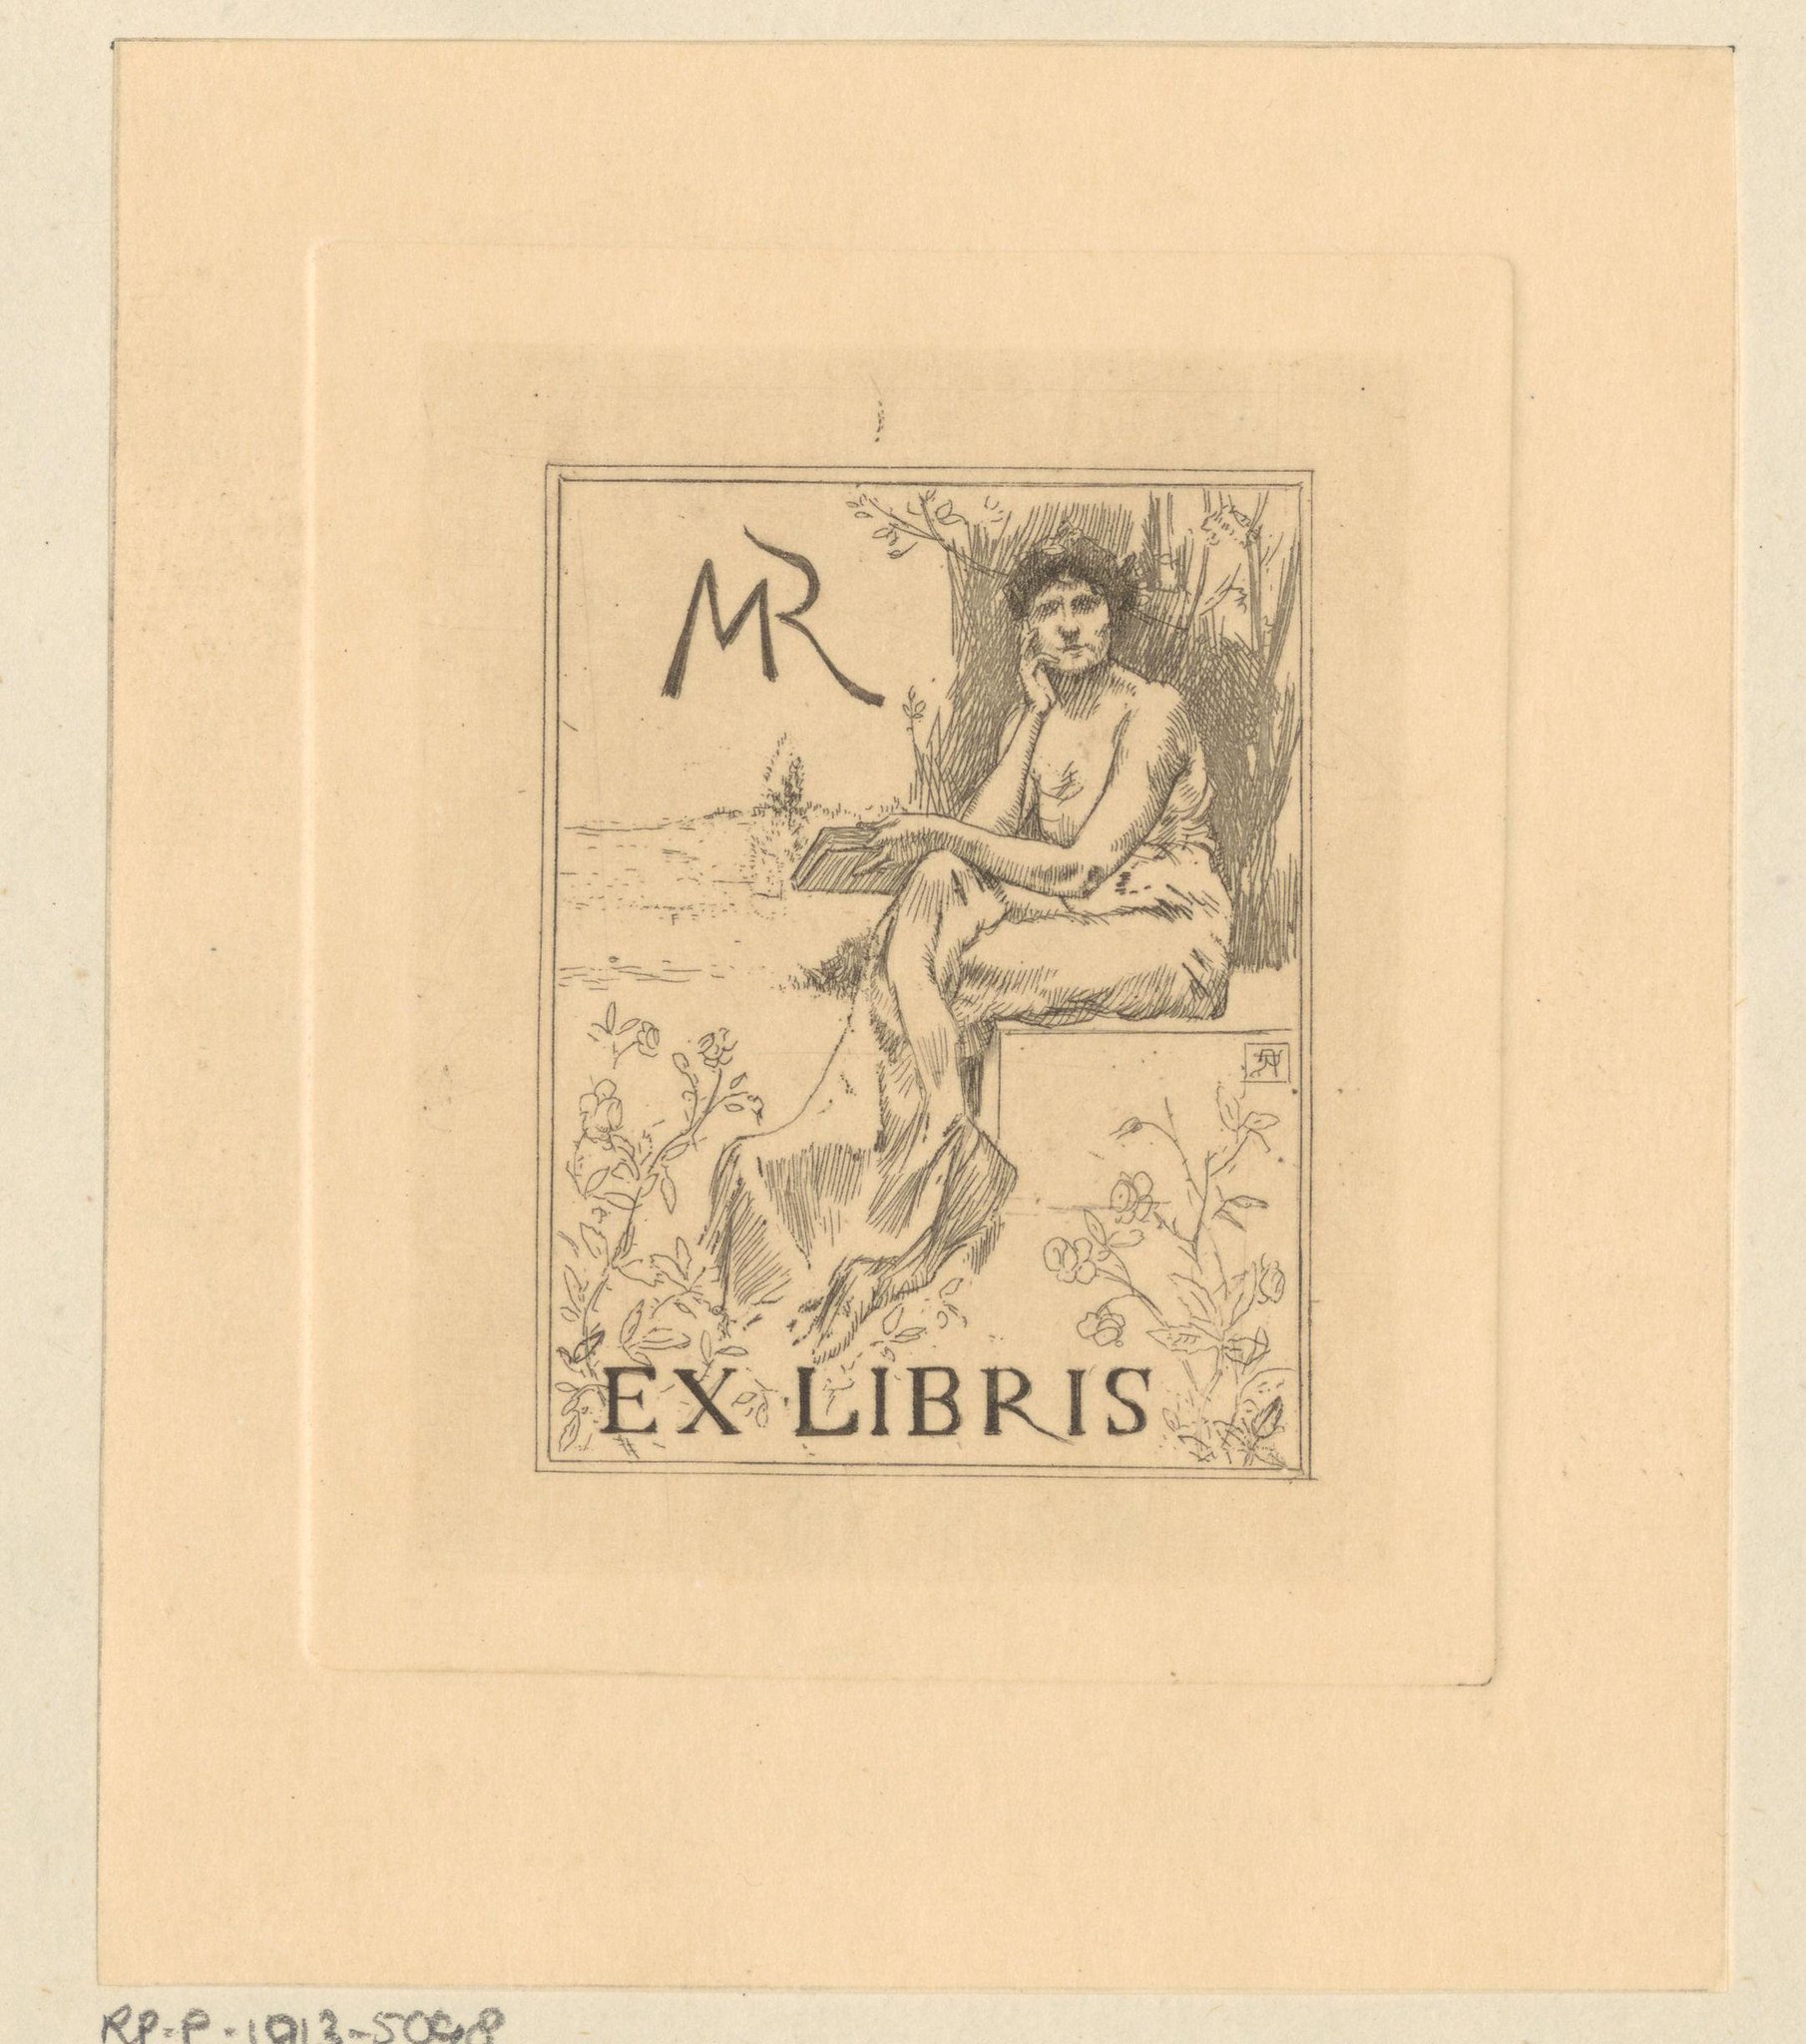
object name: bookplate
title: Ex libris M.R.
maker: armand rassenfosse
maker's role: draughtsman, painter, print maker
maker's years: 1862-1934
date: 1884-1913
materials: paper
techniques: etching, intaglio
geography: belgium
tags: flowers, sitting figure, book, man (showing himself) undressed, quasi-nude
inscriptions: collector's mark: Lugt 2760, collector's mark: Lugt 2233